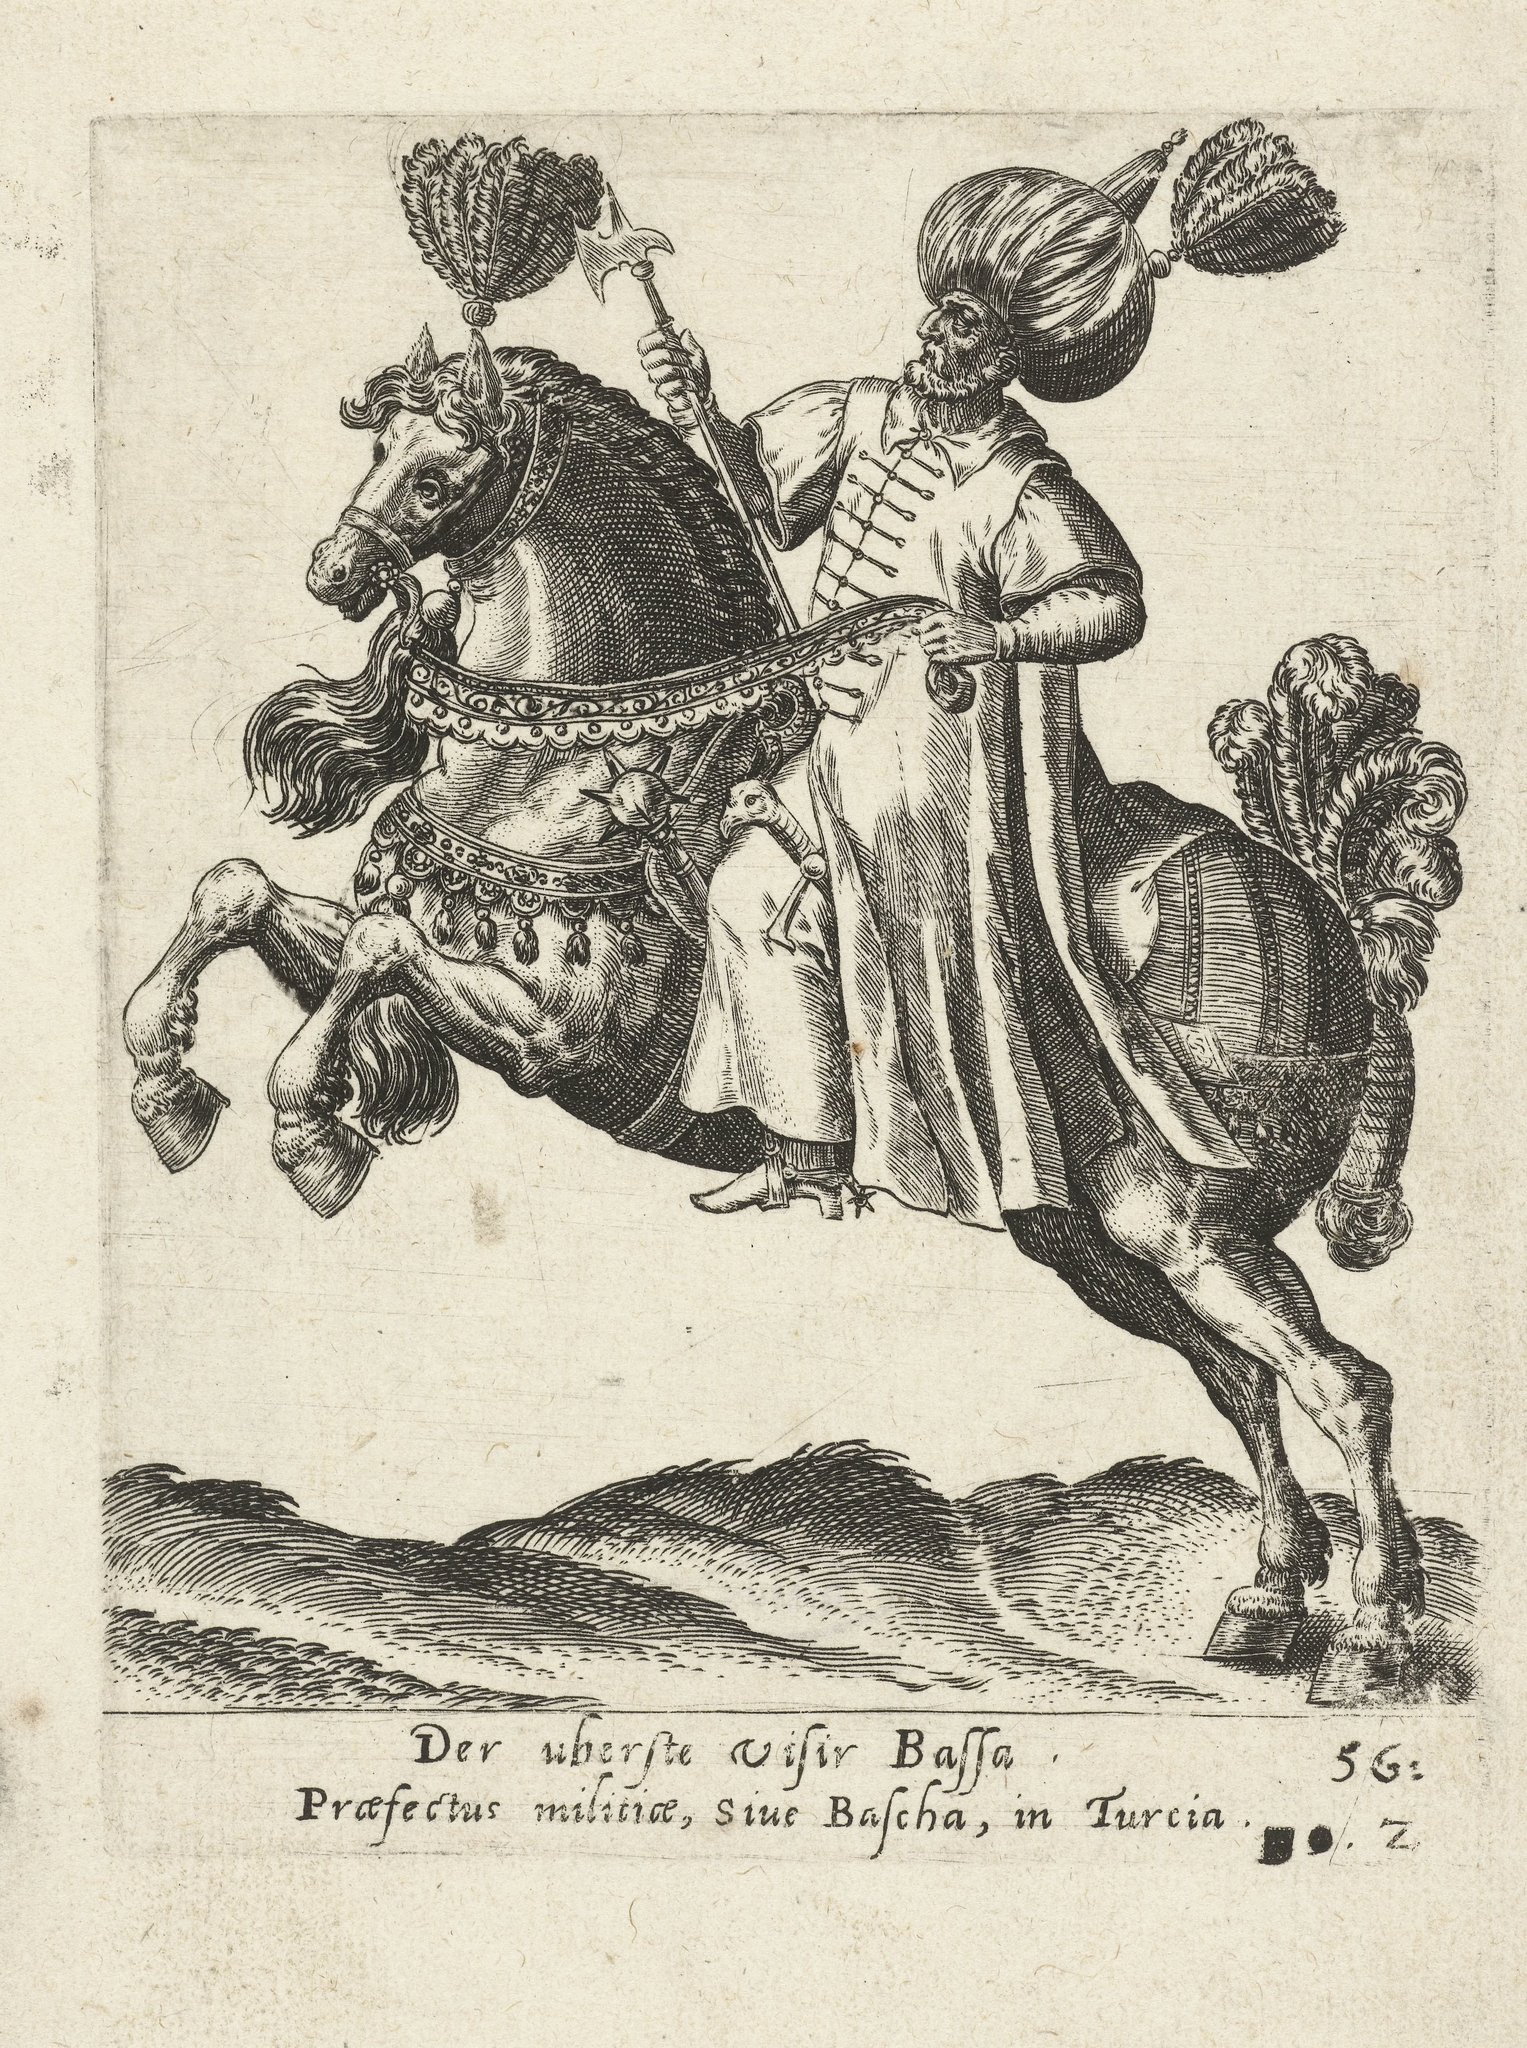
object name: costume print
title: Groot-vizier Ibrahim Pasha te paard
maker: abraham de bruyn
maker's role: print maker, publisher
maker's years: 1540-1587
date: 1577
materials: paper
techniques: engraving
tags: asiatic races and peoples: turks, warfare; military affairs (+ cavalry, horsemen), folk costume, regional costume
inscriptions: collector's mark: Lugt 2228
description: Paard en ruiter naar links. Het paard steigert. Groot-vizier Ibrahim Pasha is in Ottomaanse stijl gekleed en heeft een bijl in zijn handen. De prent heeft een Duits en Latijns onderschrift. Prent oorspronkelijk uit 'Equitum descripcio...', 1577.